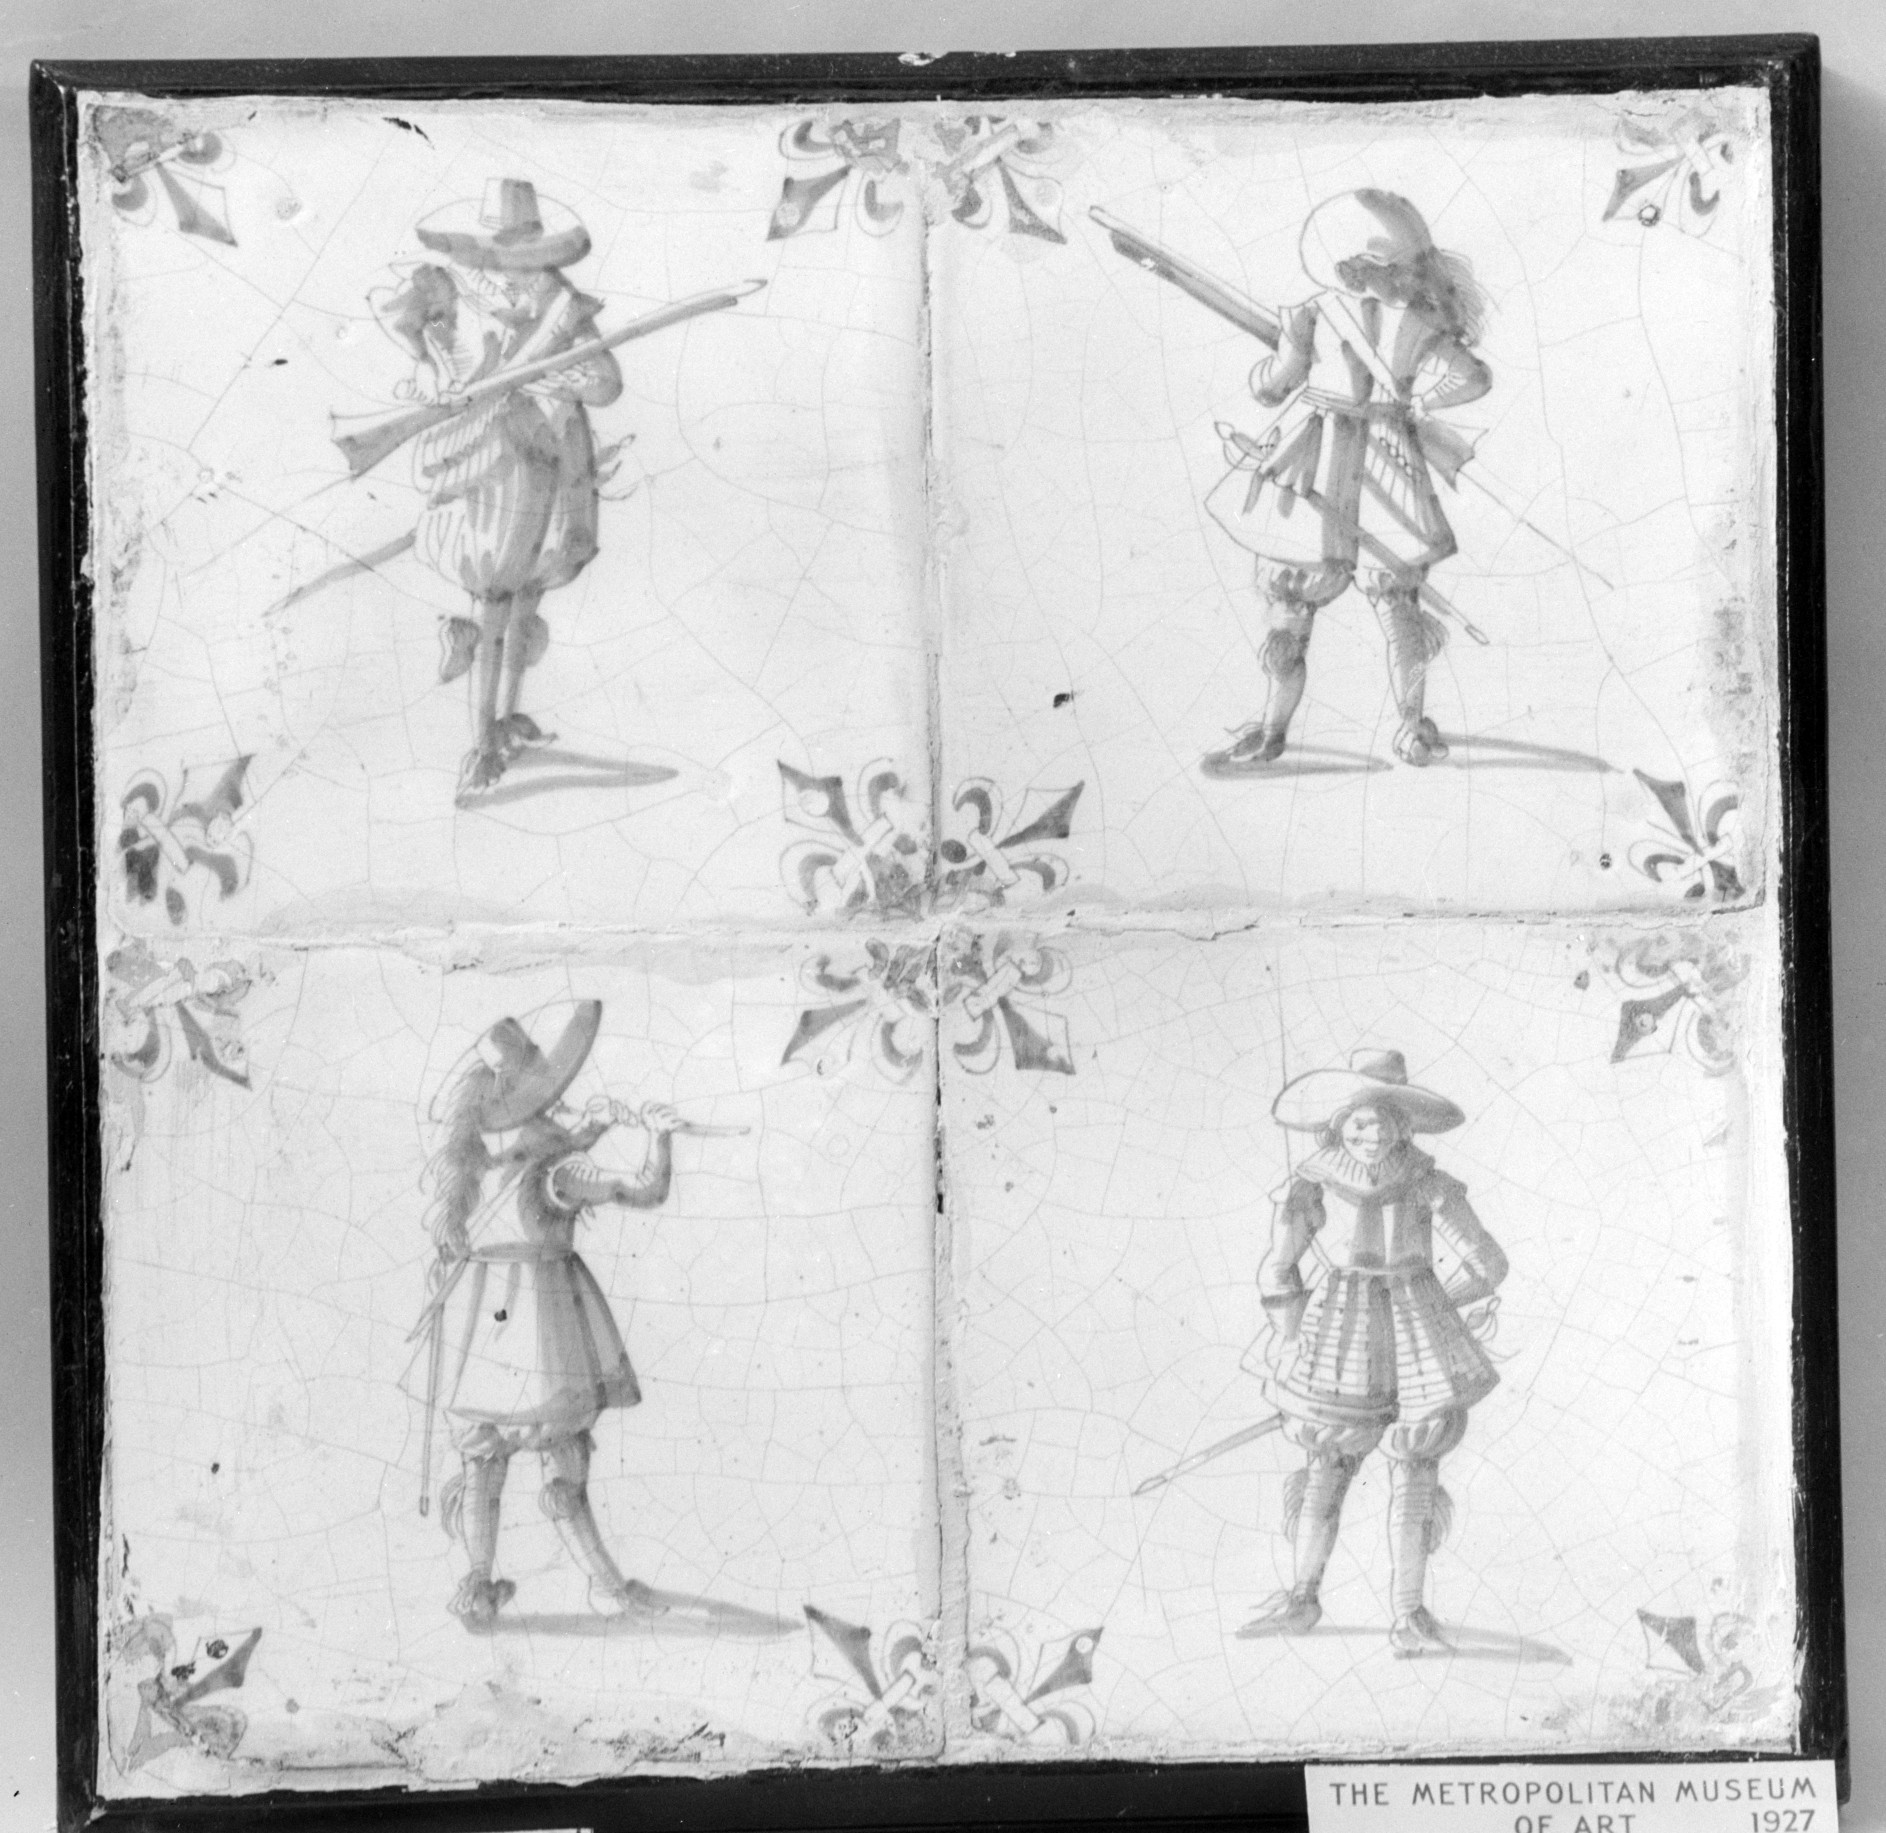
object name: tile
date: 1620-1650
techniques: glazing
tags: firearms,women